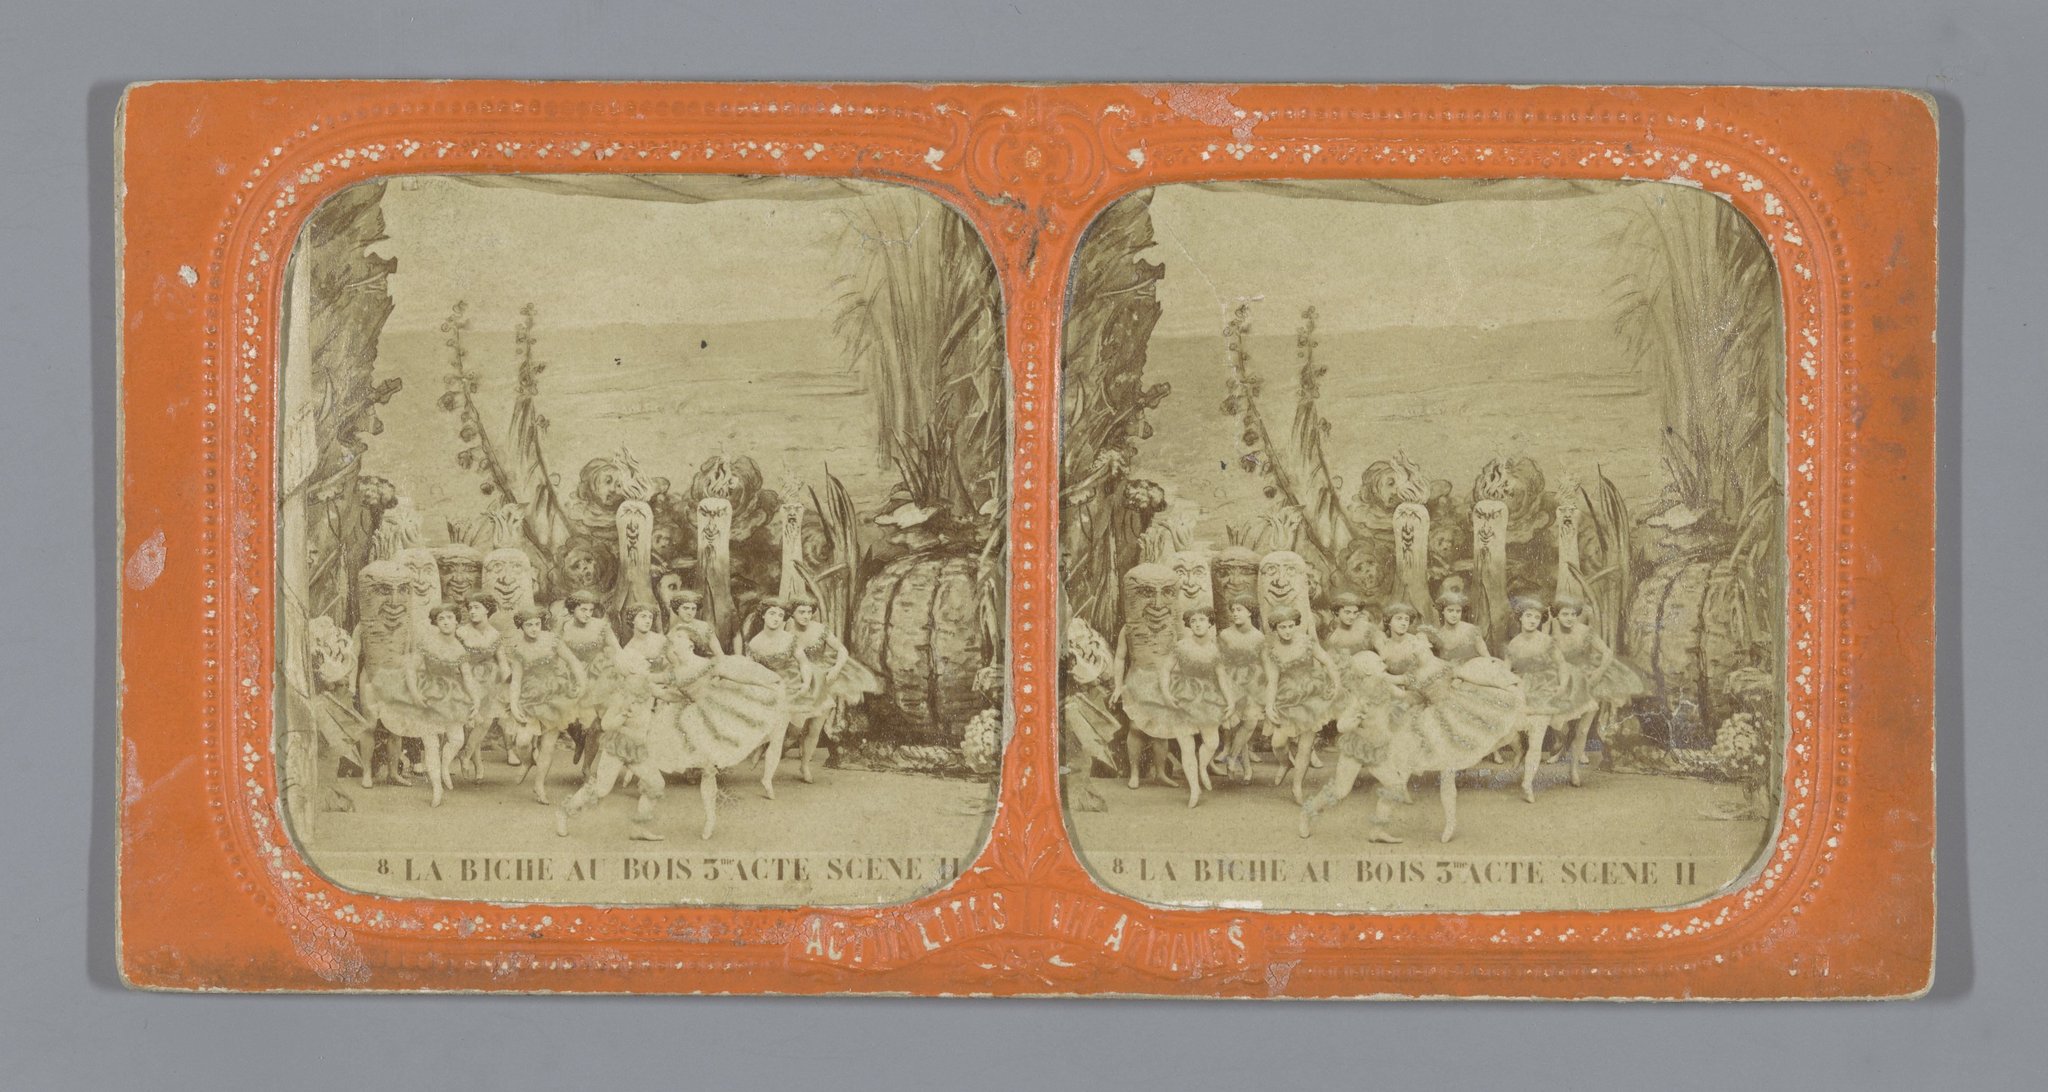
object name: tissue stereograph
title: Actualites theatrales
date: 1864-1875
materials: cardboard, paper, photographic support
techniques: albumen print, hand coloring, perforating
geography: paris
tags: opera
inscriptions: number: ‘8.’